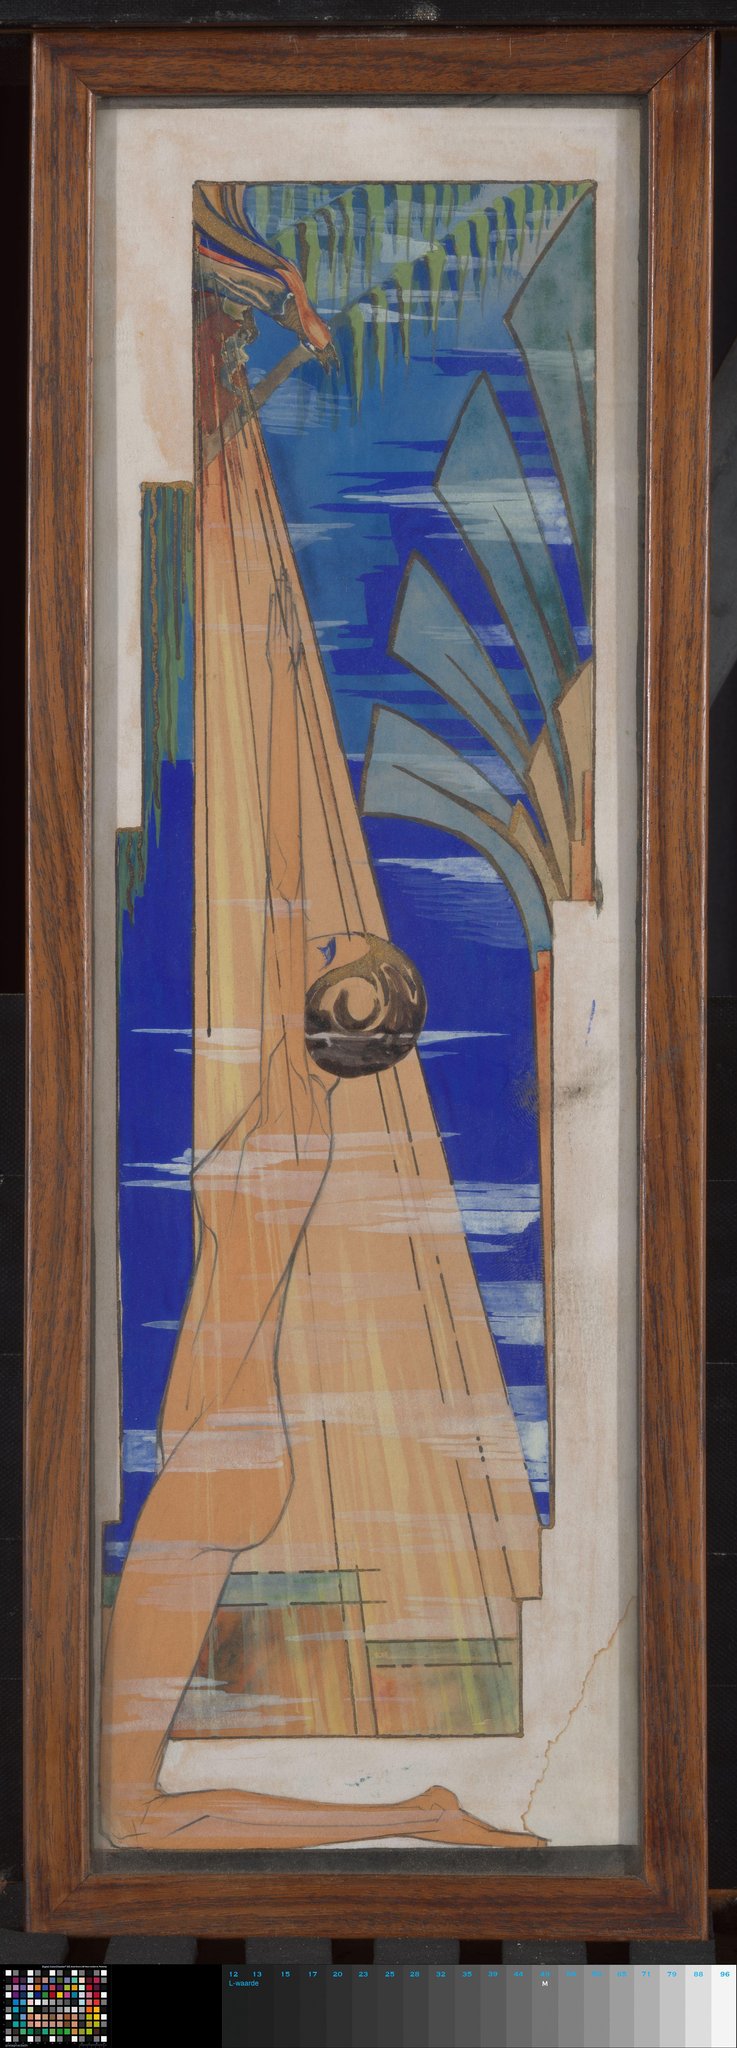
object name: betimmering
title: Schildering van een naakt vrouwfiguur op haar knieën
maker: Anonymous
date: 1900-1920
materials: glass, paint, pencil, wood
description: Schildering van een naakt vrouwfiguur op haar knieën met uitreikende armen naar boven tegen een blauwe achtergrond met art nouveau ornamenten. Linksboven een kleurrijke vogel waar ook de lichtbron vandaan komt en de vrouw belicht. De tekening is gemaakt op triplex in een lijst van palissander.